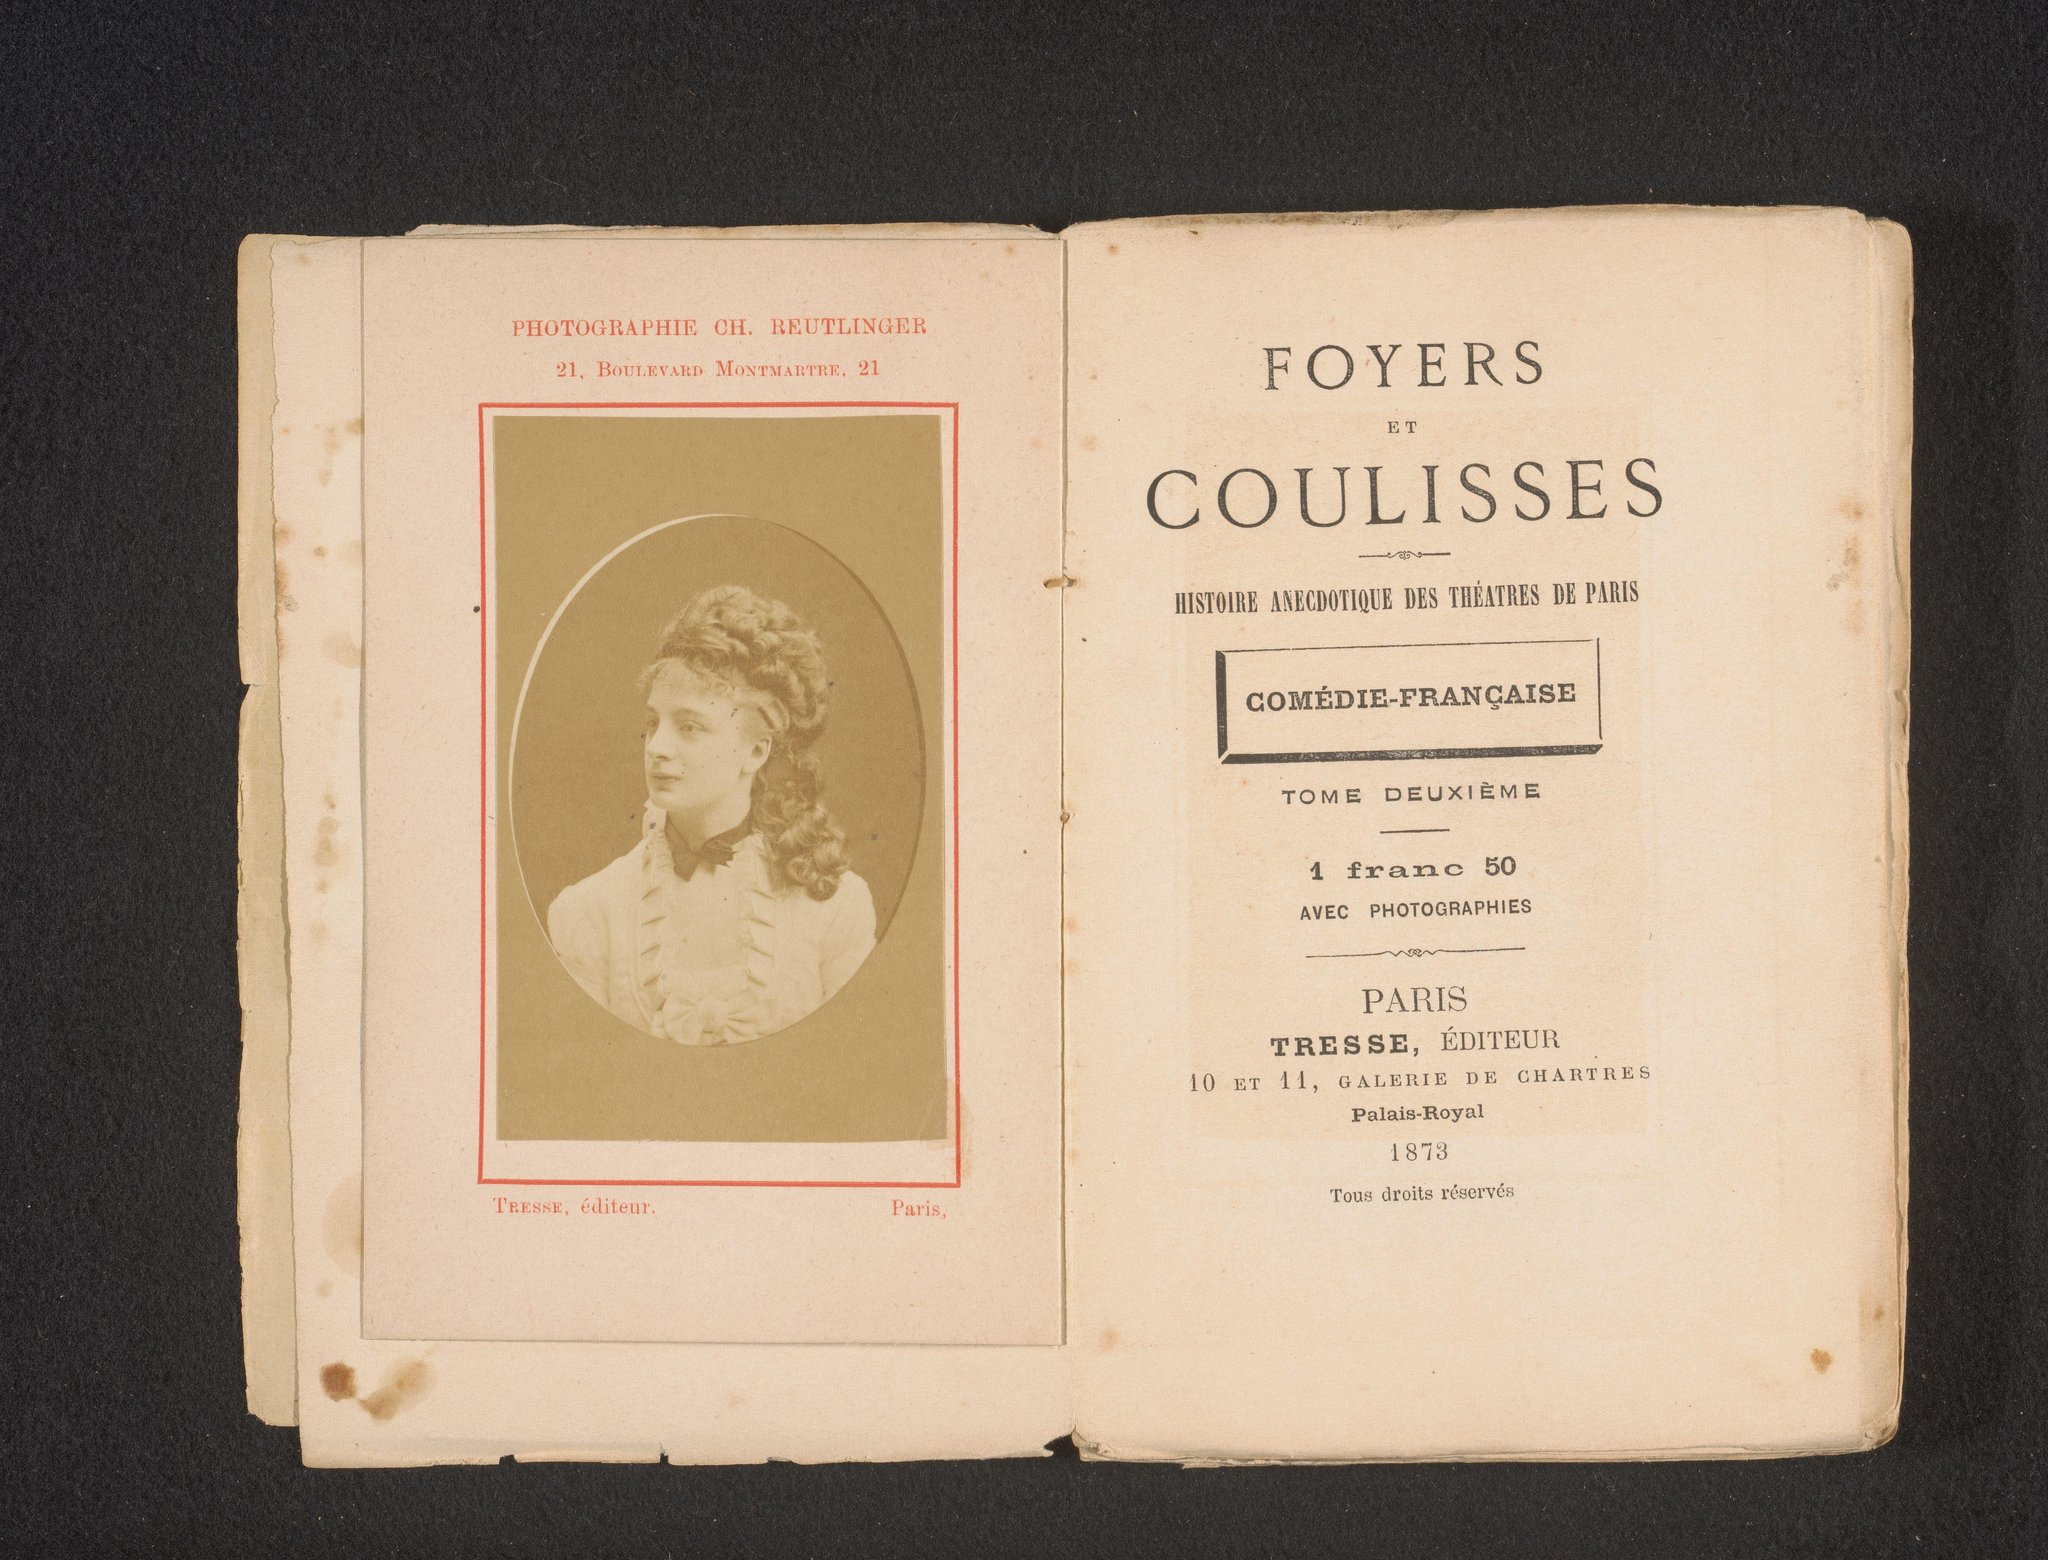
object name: photograph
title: Portret van een Franse actrice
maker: charles reutlinger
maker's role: publisher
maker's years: 1816-1880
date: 1874-1884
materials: photographic support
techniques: albumen print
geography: paris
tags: portrait of actor, actress